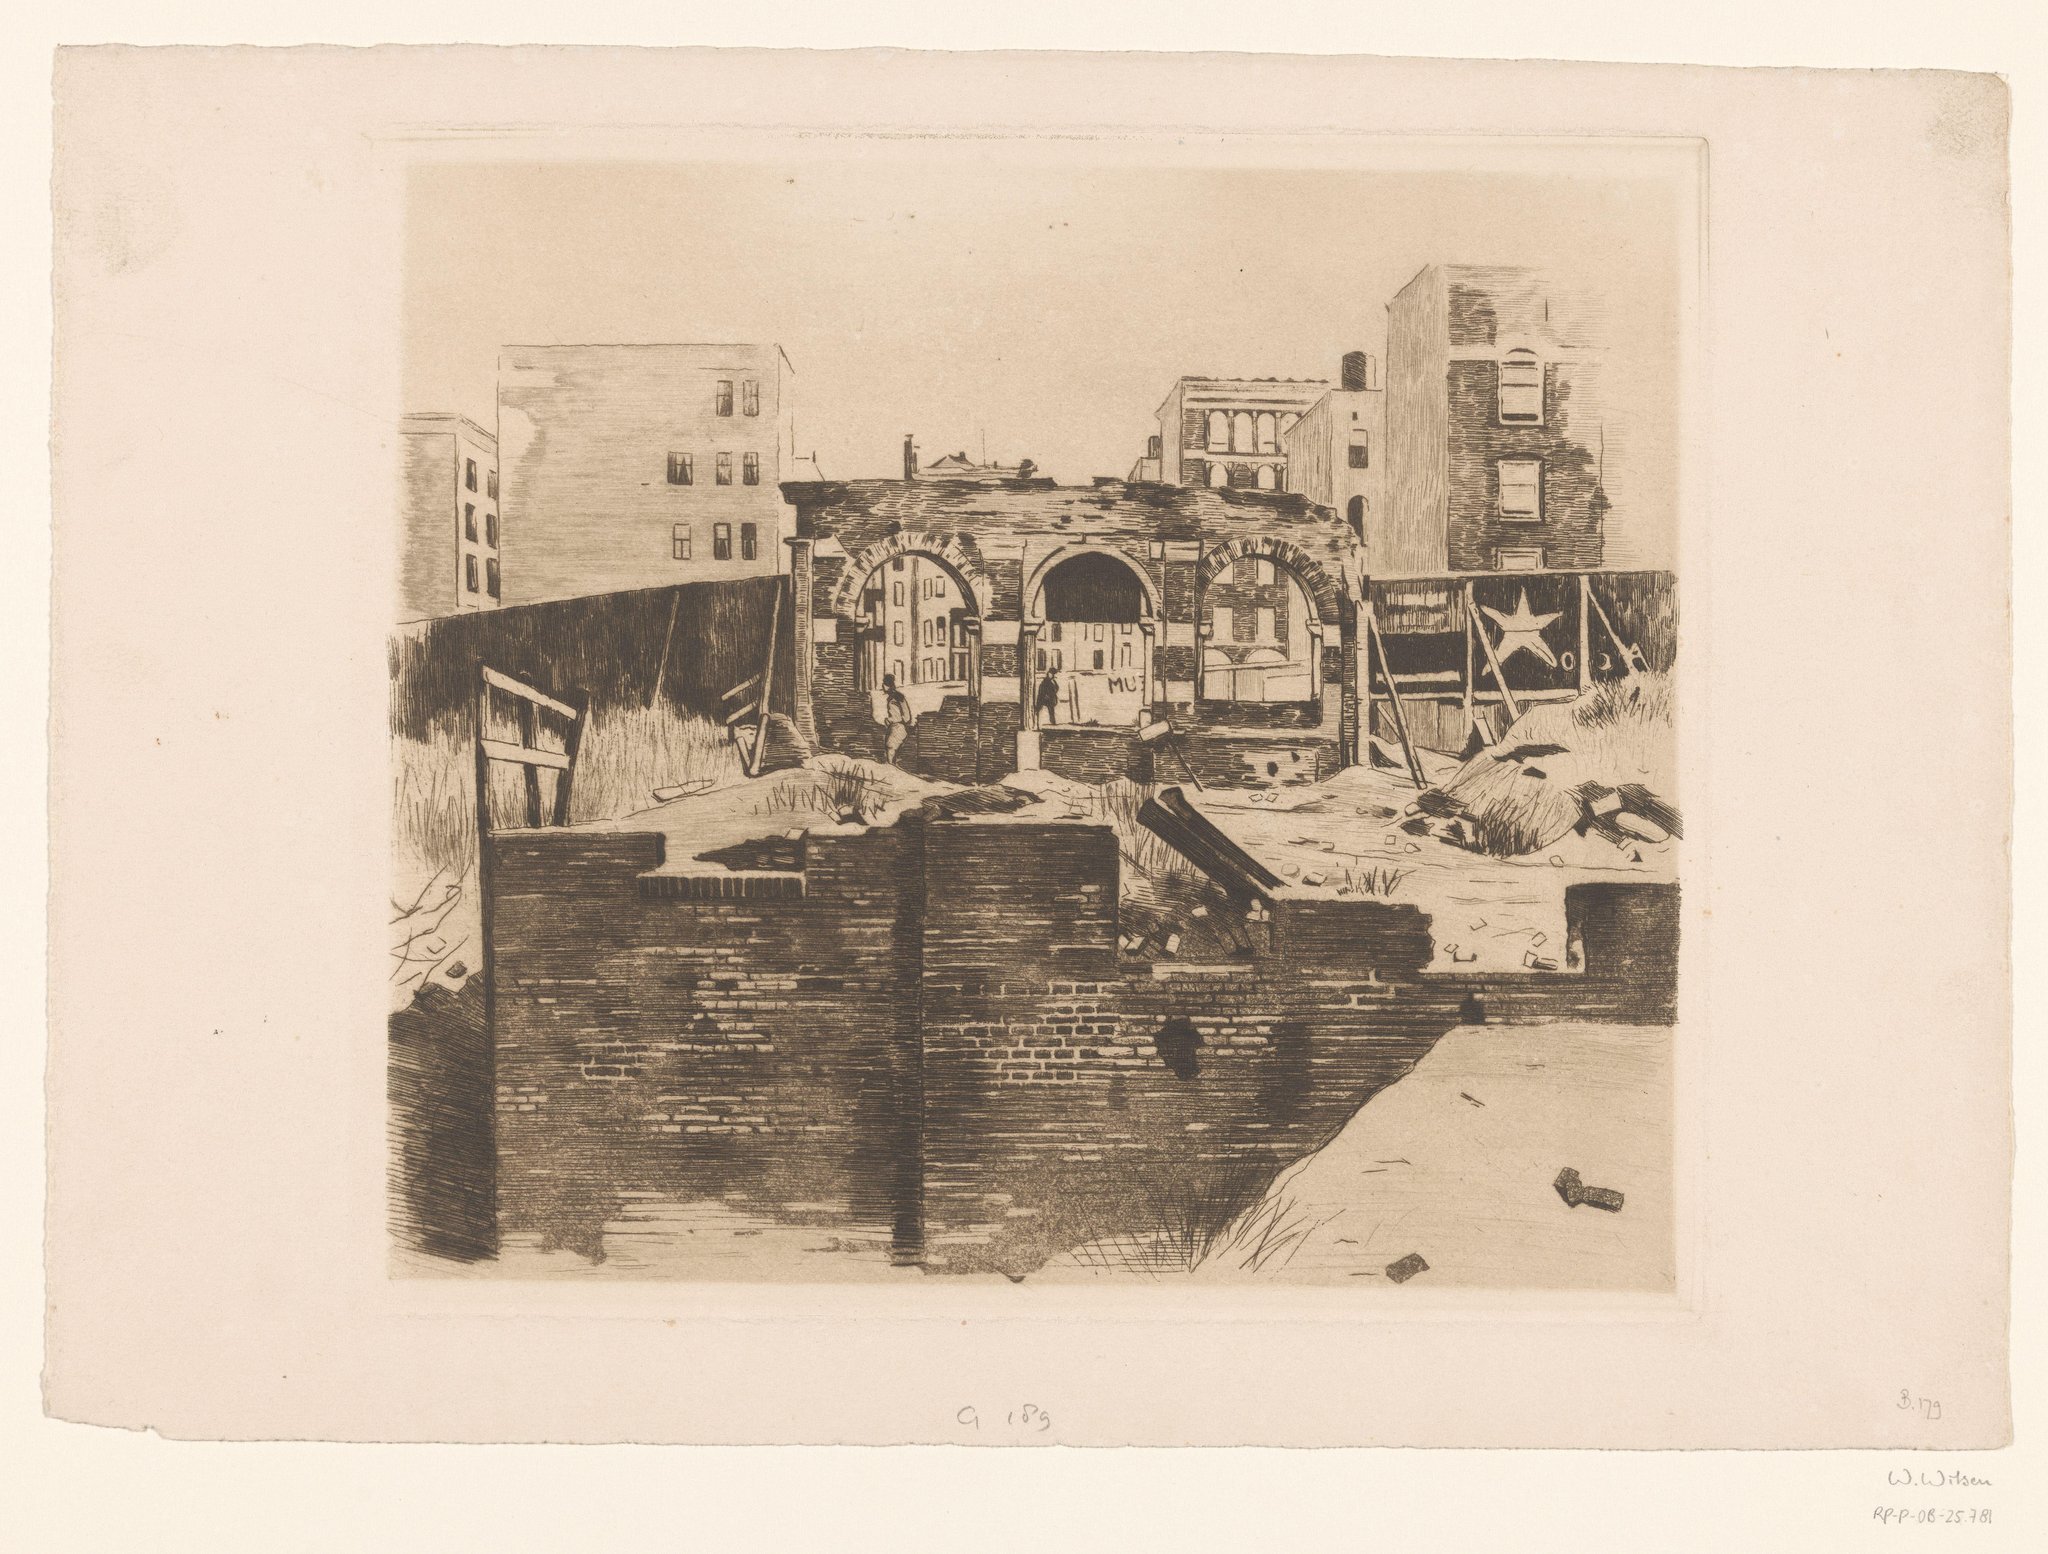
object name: print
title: Gezicht op een ruïne in Post Street te San Francisco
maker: willem witsen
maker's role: draughtsman, painter, print maker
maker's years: 1860-1923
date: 1915-1919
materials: paper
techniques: aquatint, etching, intaglio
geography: amsterdam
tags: city-view in general; 'veduta', ruin of a building ~ architecture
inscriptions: watermark